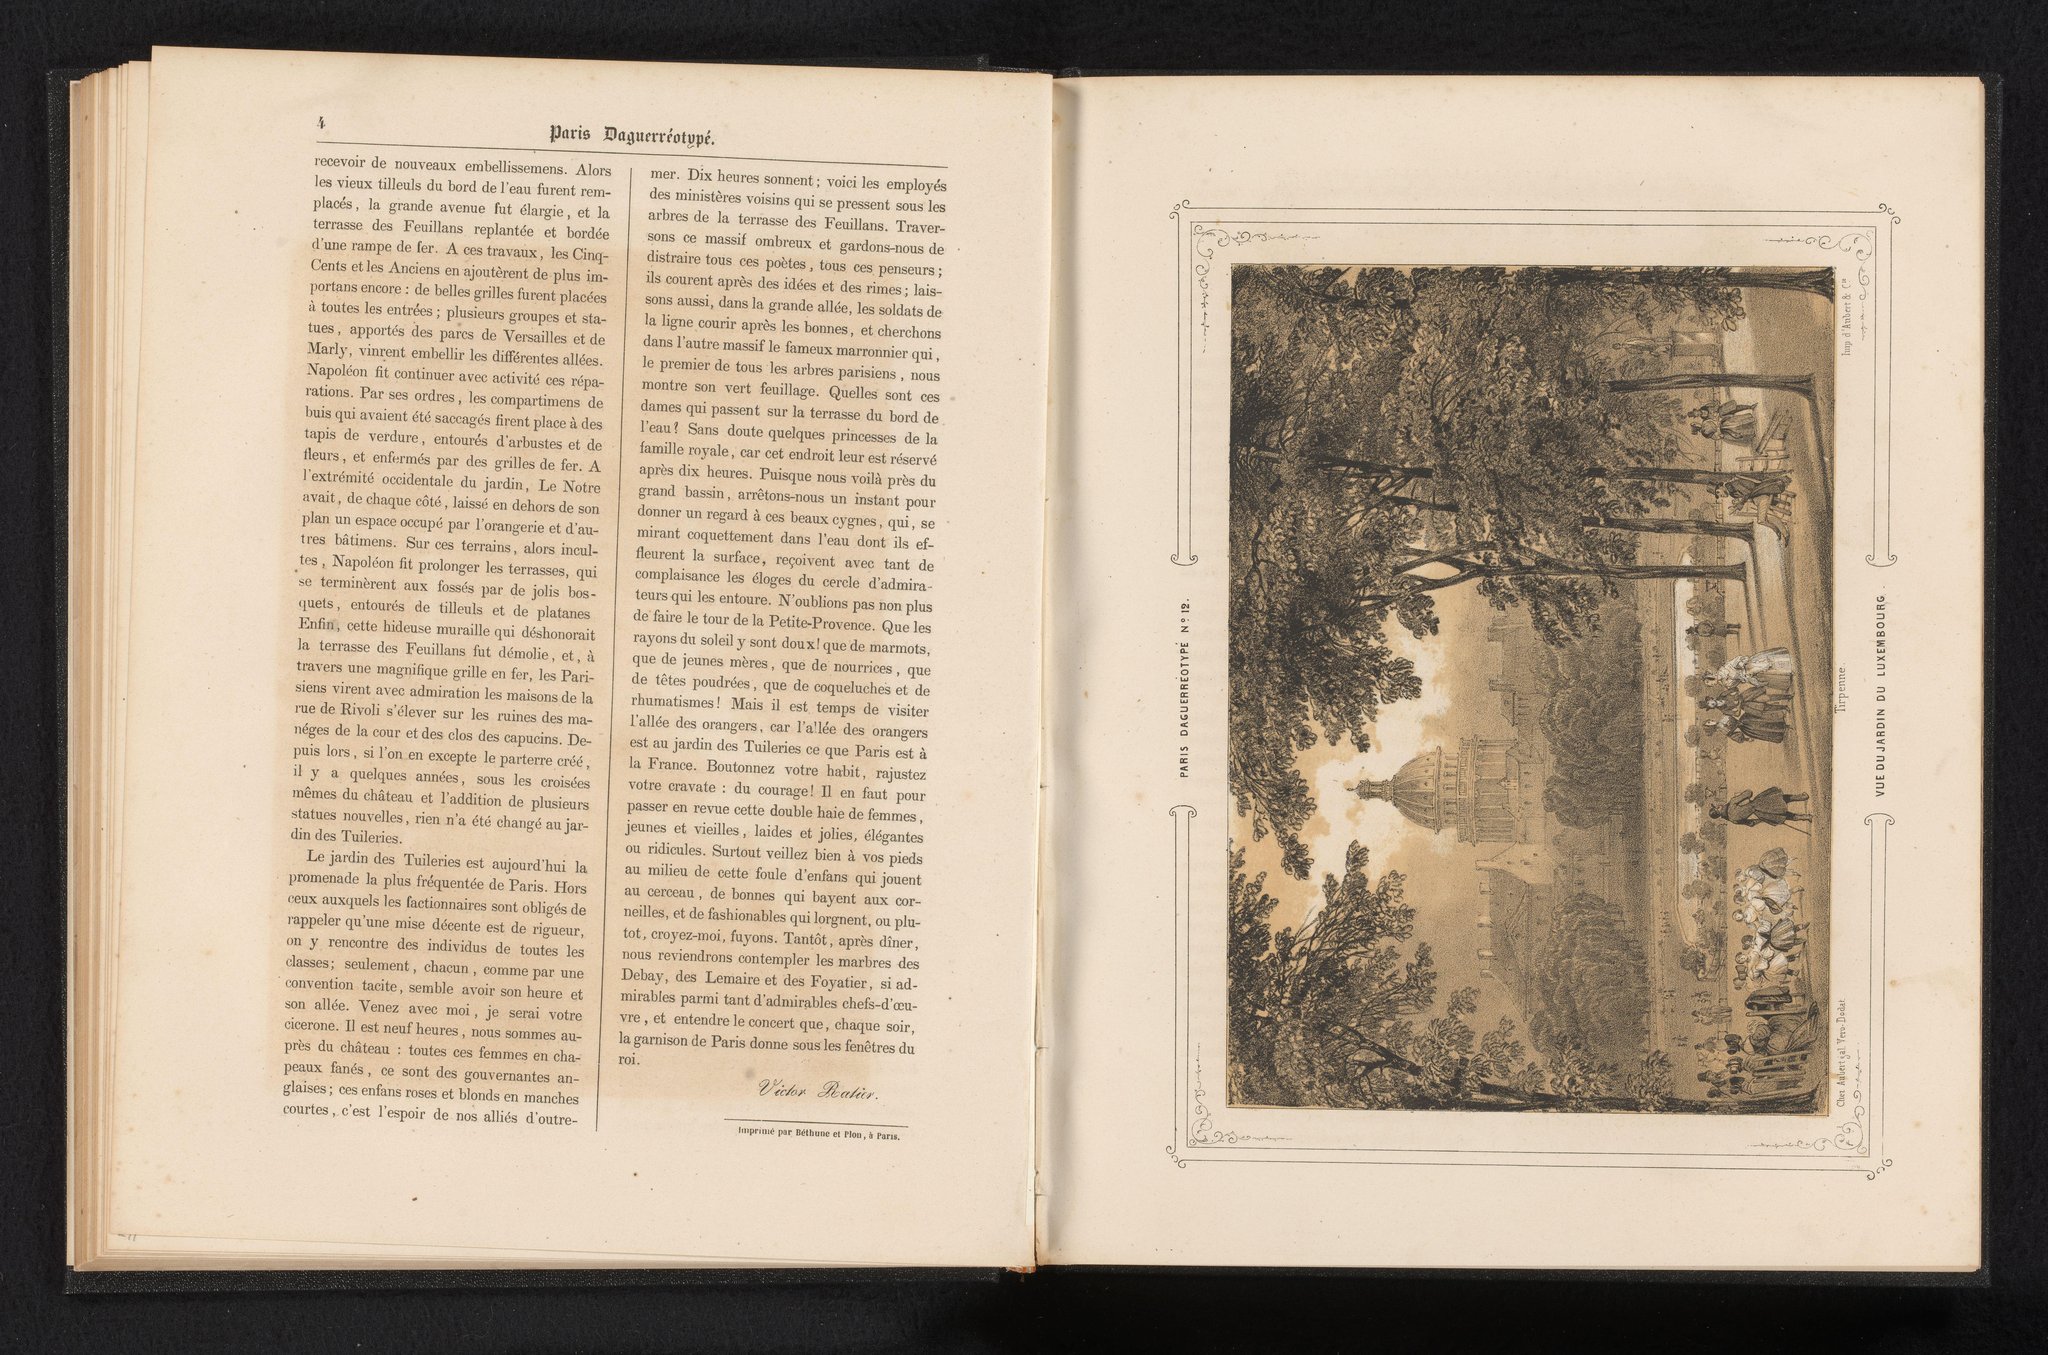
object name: print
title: Vue du Jardin du Luxembourg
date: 1839-1840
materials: paper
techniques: tone lithography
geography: paris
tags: park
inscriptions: inscription: ‘PARIS DAGUERRÉOTYPÉ No. 12.’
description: Prent op vijfenveertigste ongenummerde pagina.